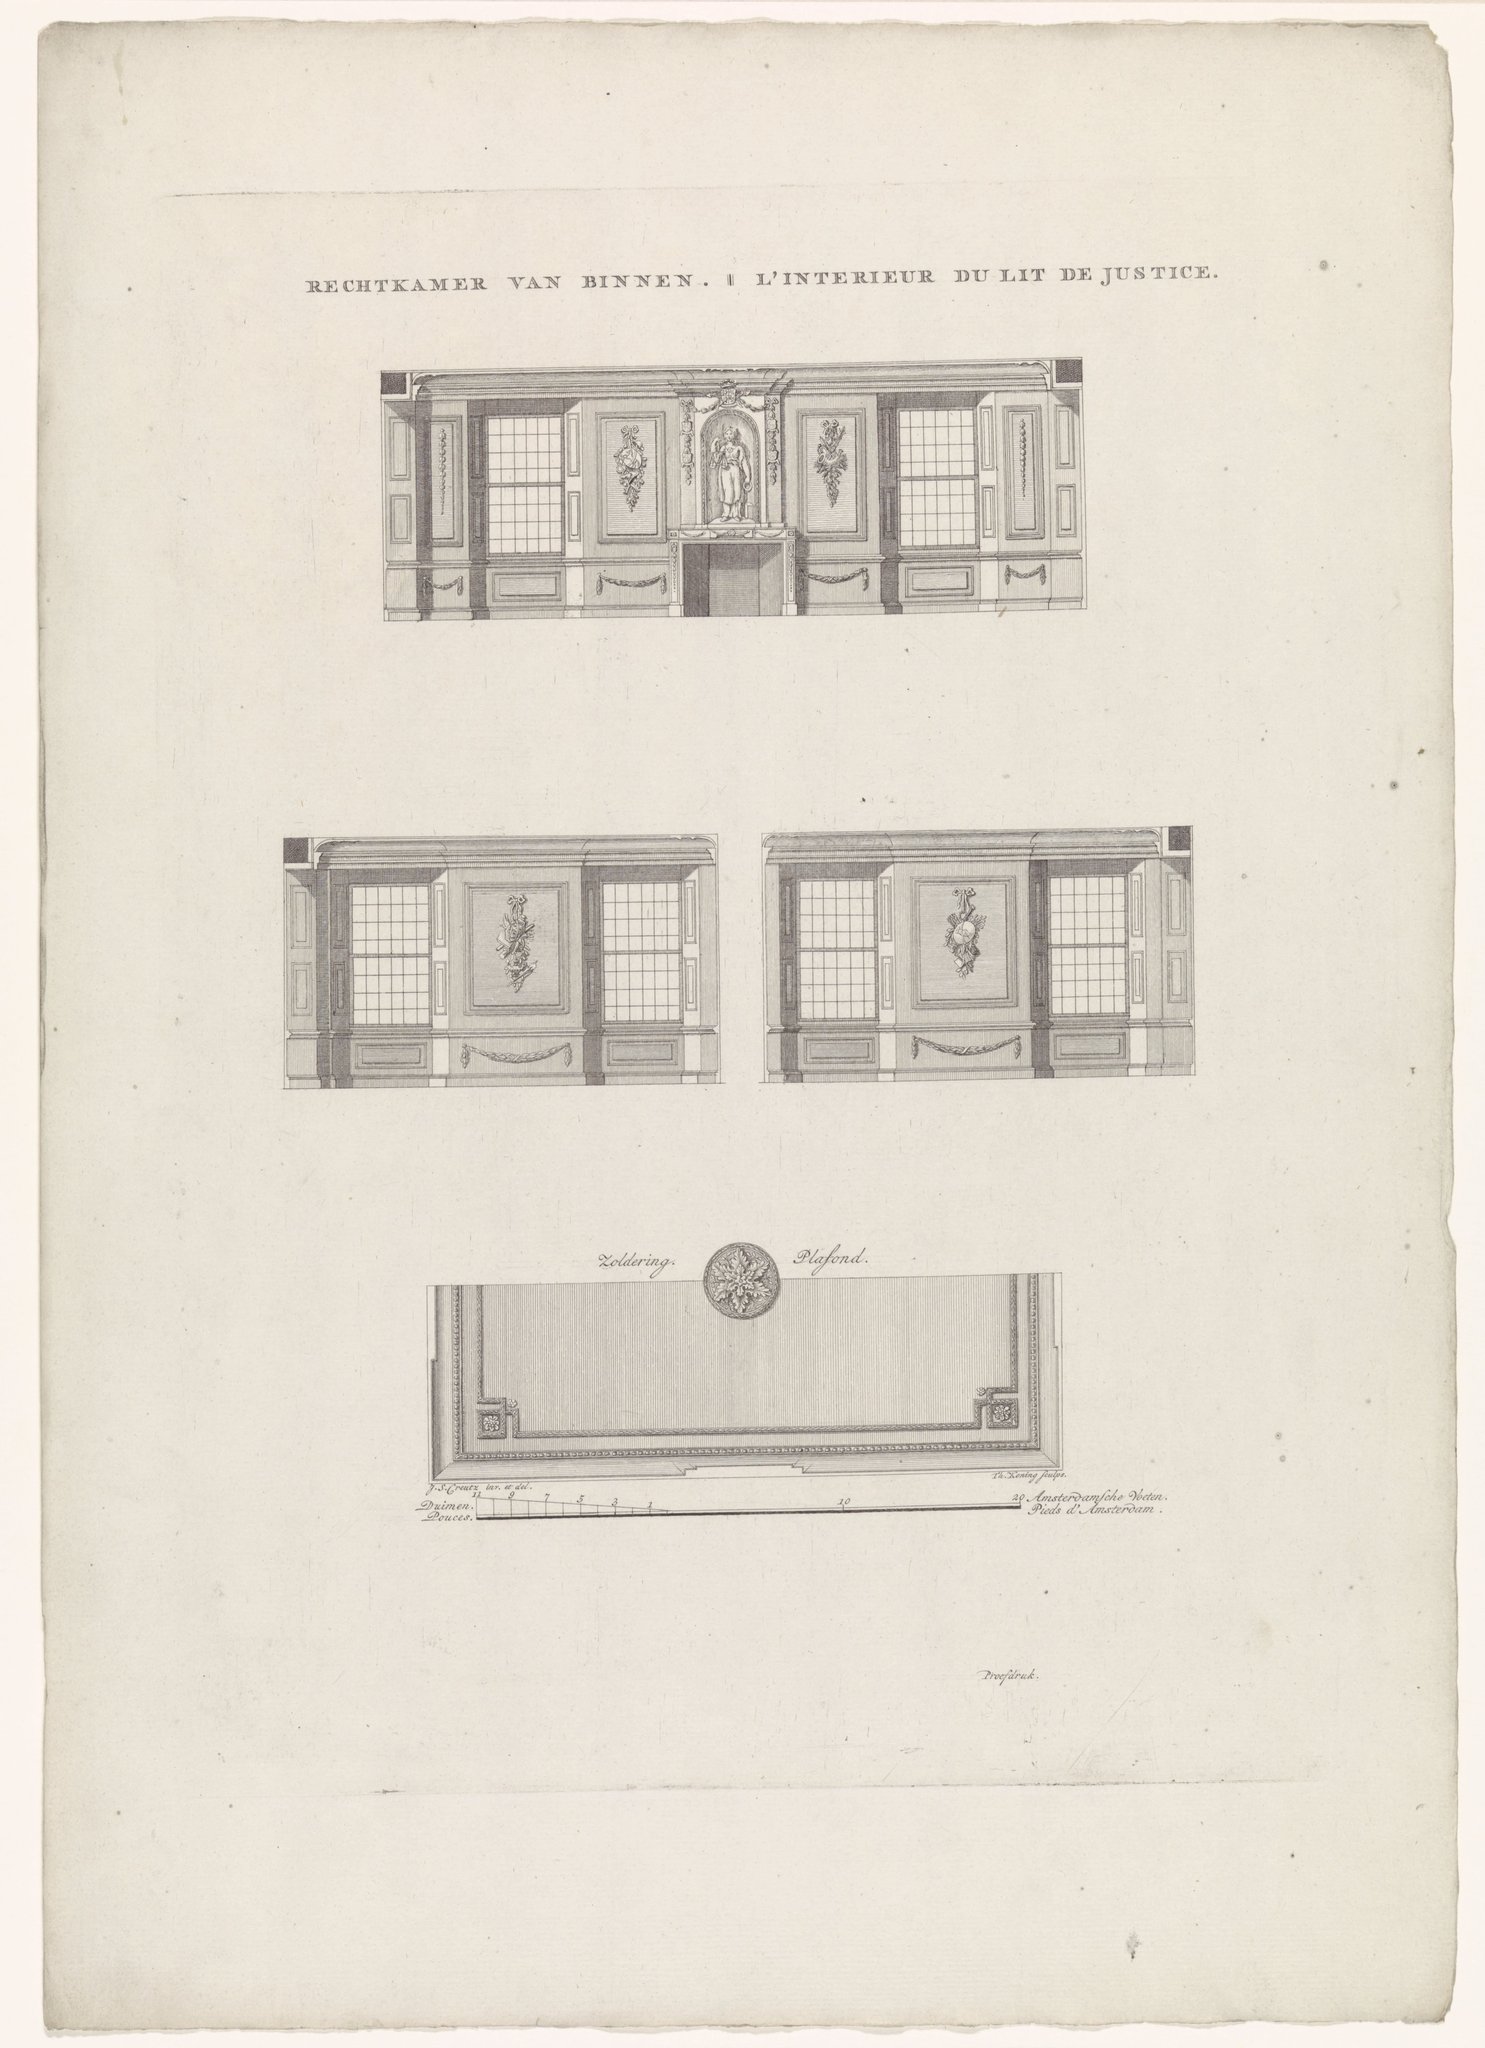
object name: print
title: Rechtkamer van binnen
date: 1782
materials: paper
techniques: etching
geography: amsterdam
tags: interior ~ representation of a building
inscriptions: collector's mark: Lugt 2228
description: Vier aanzichten op het gedecoreerde interieur van de rechtkamer, inclusief het plafont. Onder de aanzichten een schaalverdeling. De prent maakt deel uit van een serie met tien afbeeldingen van de rechtbank te Westzaan.